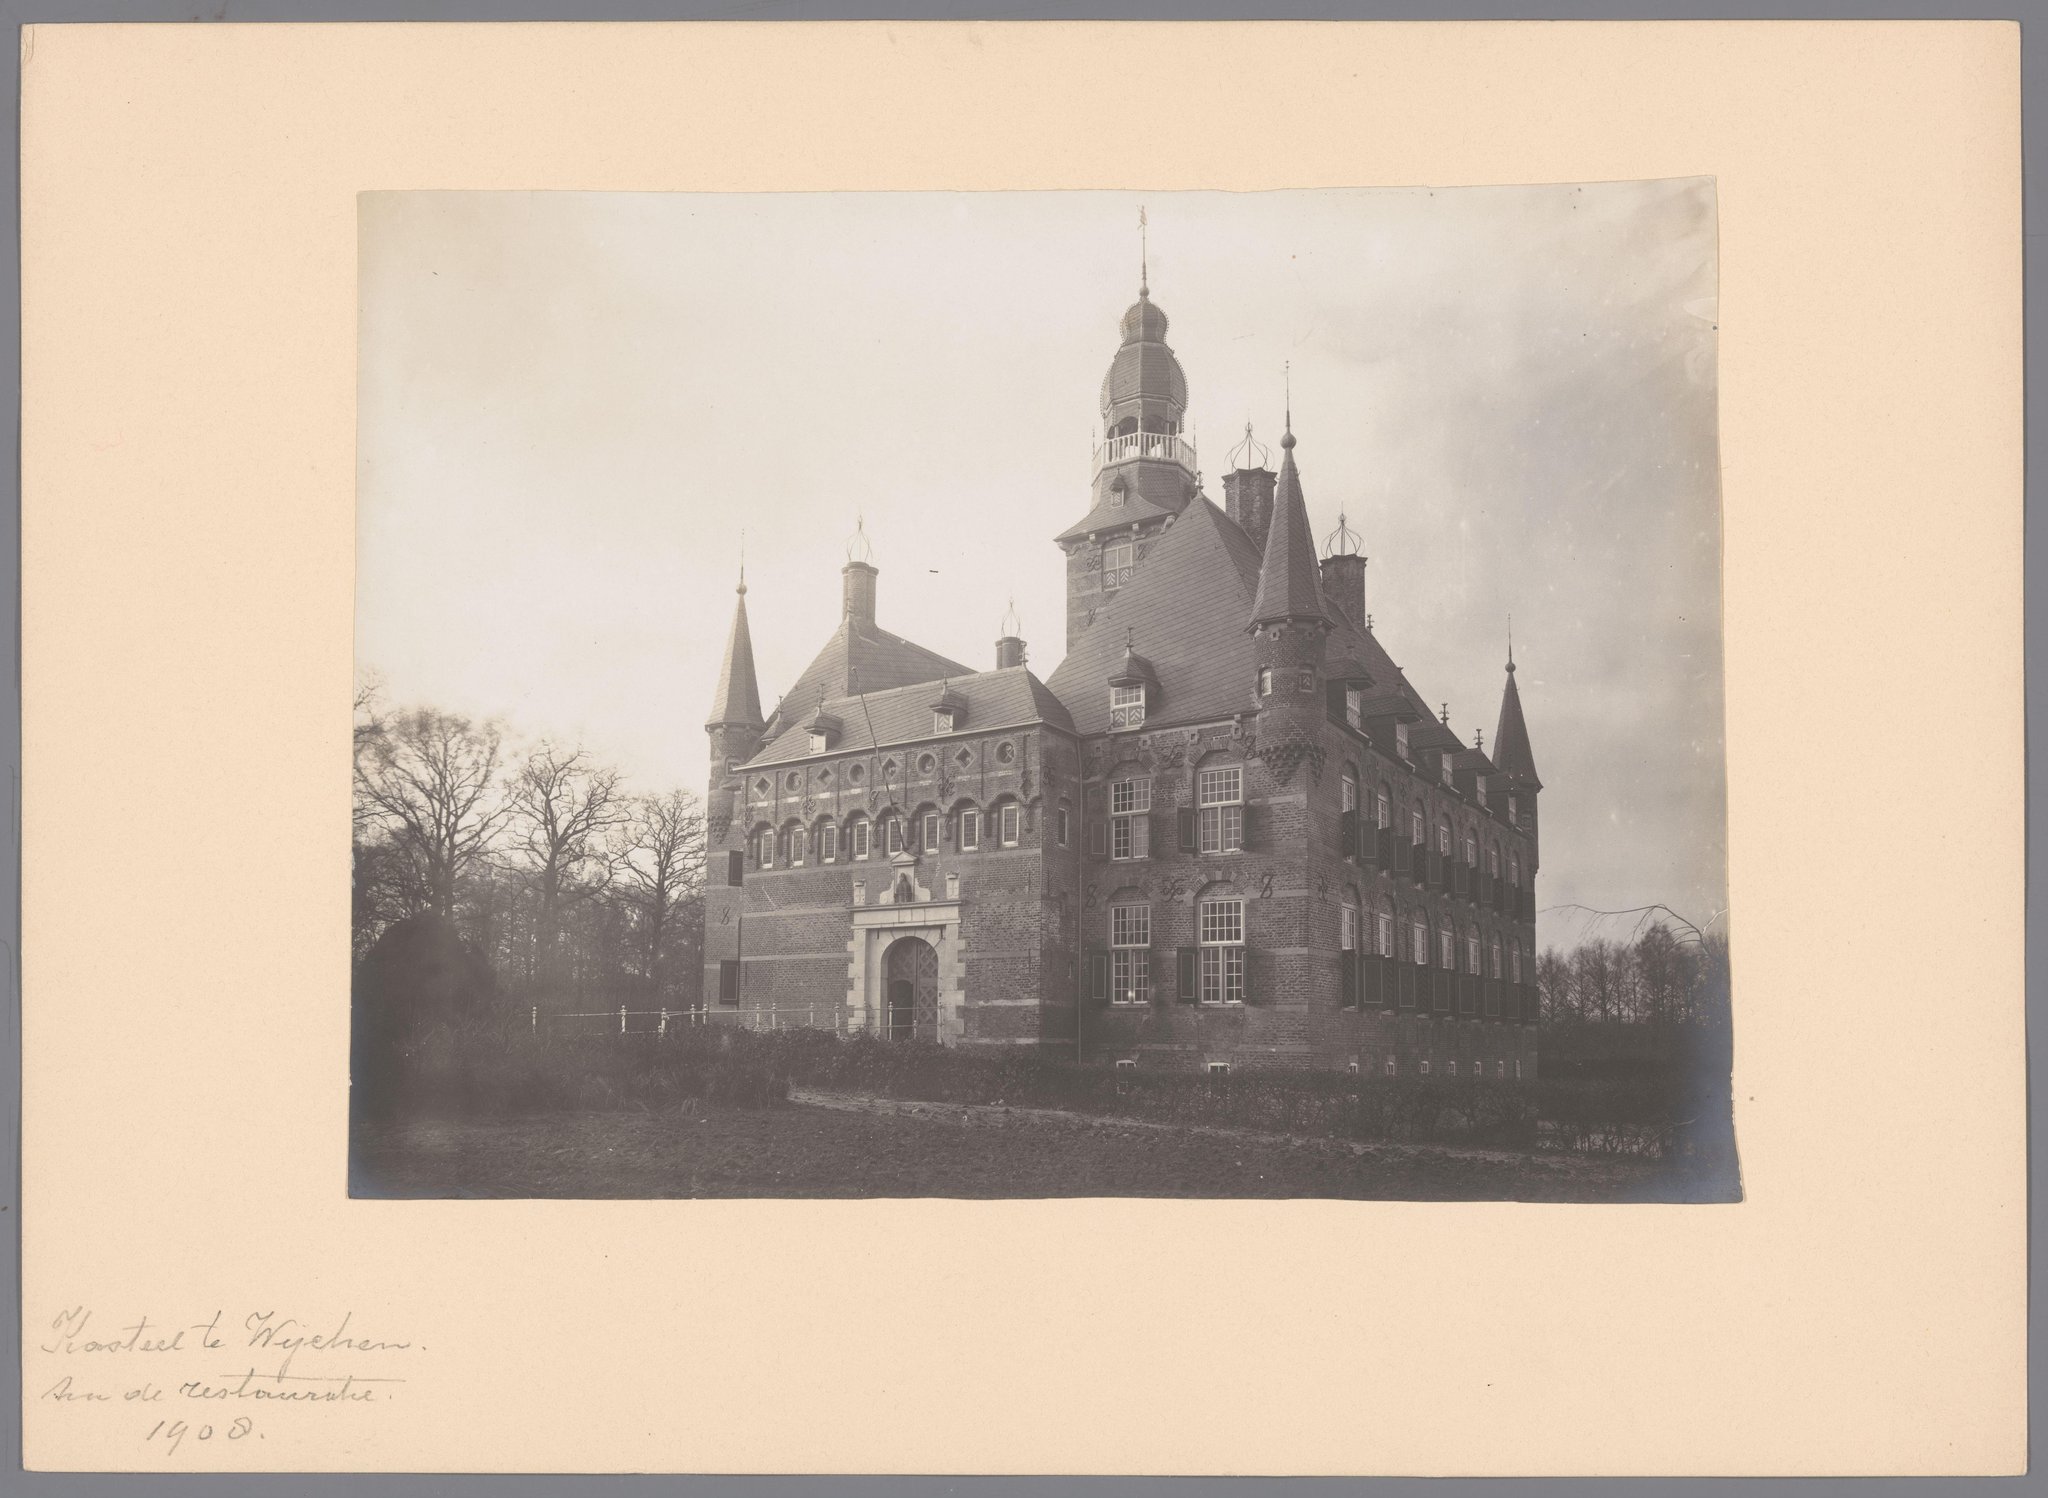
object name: photograph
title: Gezicht op het Kasteel van Wijchen na de restauratie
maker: anoniem (monumentenzorg)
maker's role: fotograaf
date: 1908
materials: cardboard, photographic support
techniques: gelatin silver print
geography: wijchen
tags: castle, landscape with tower or castle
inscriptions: annotation: ‘Kasteel te Wijchen na de restauratie 1908’